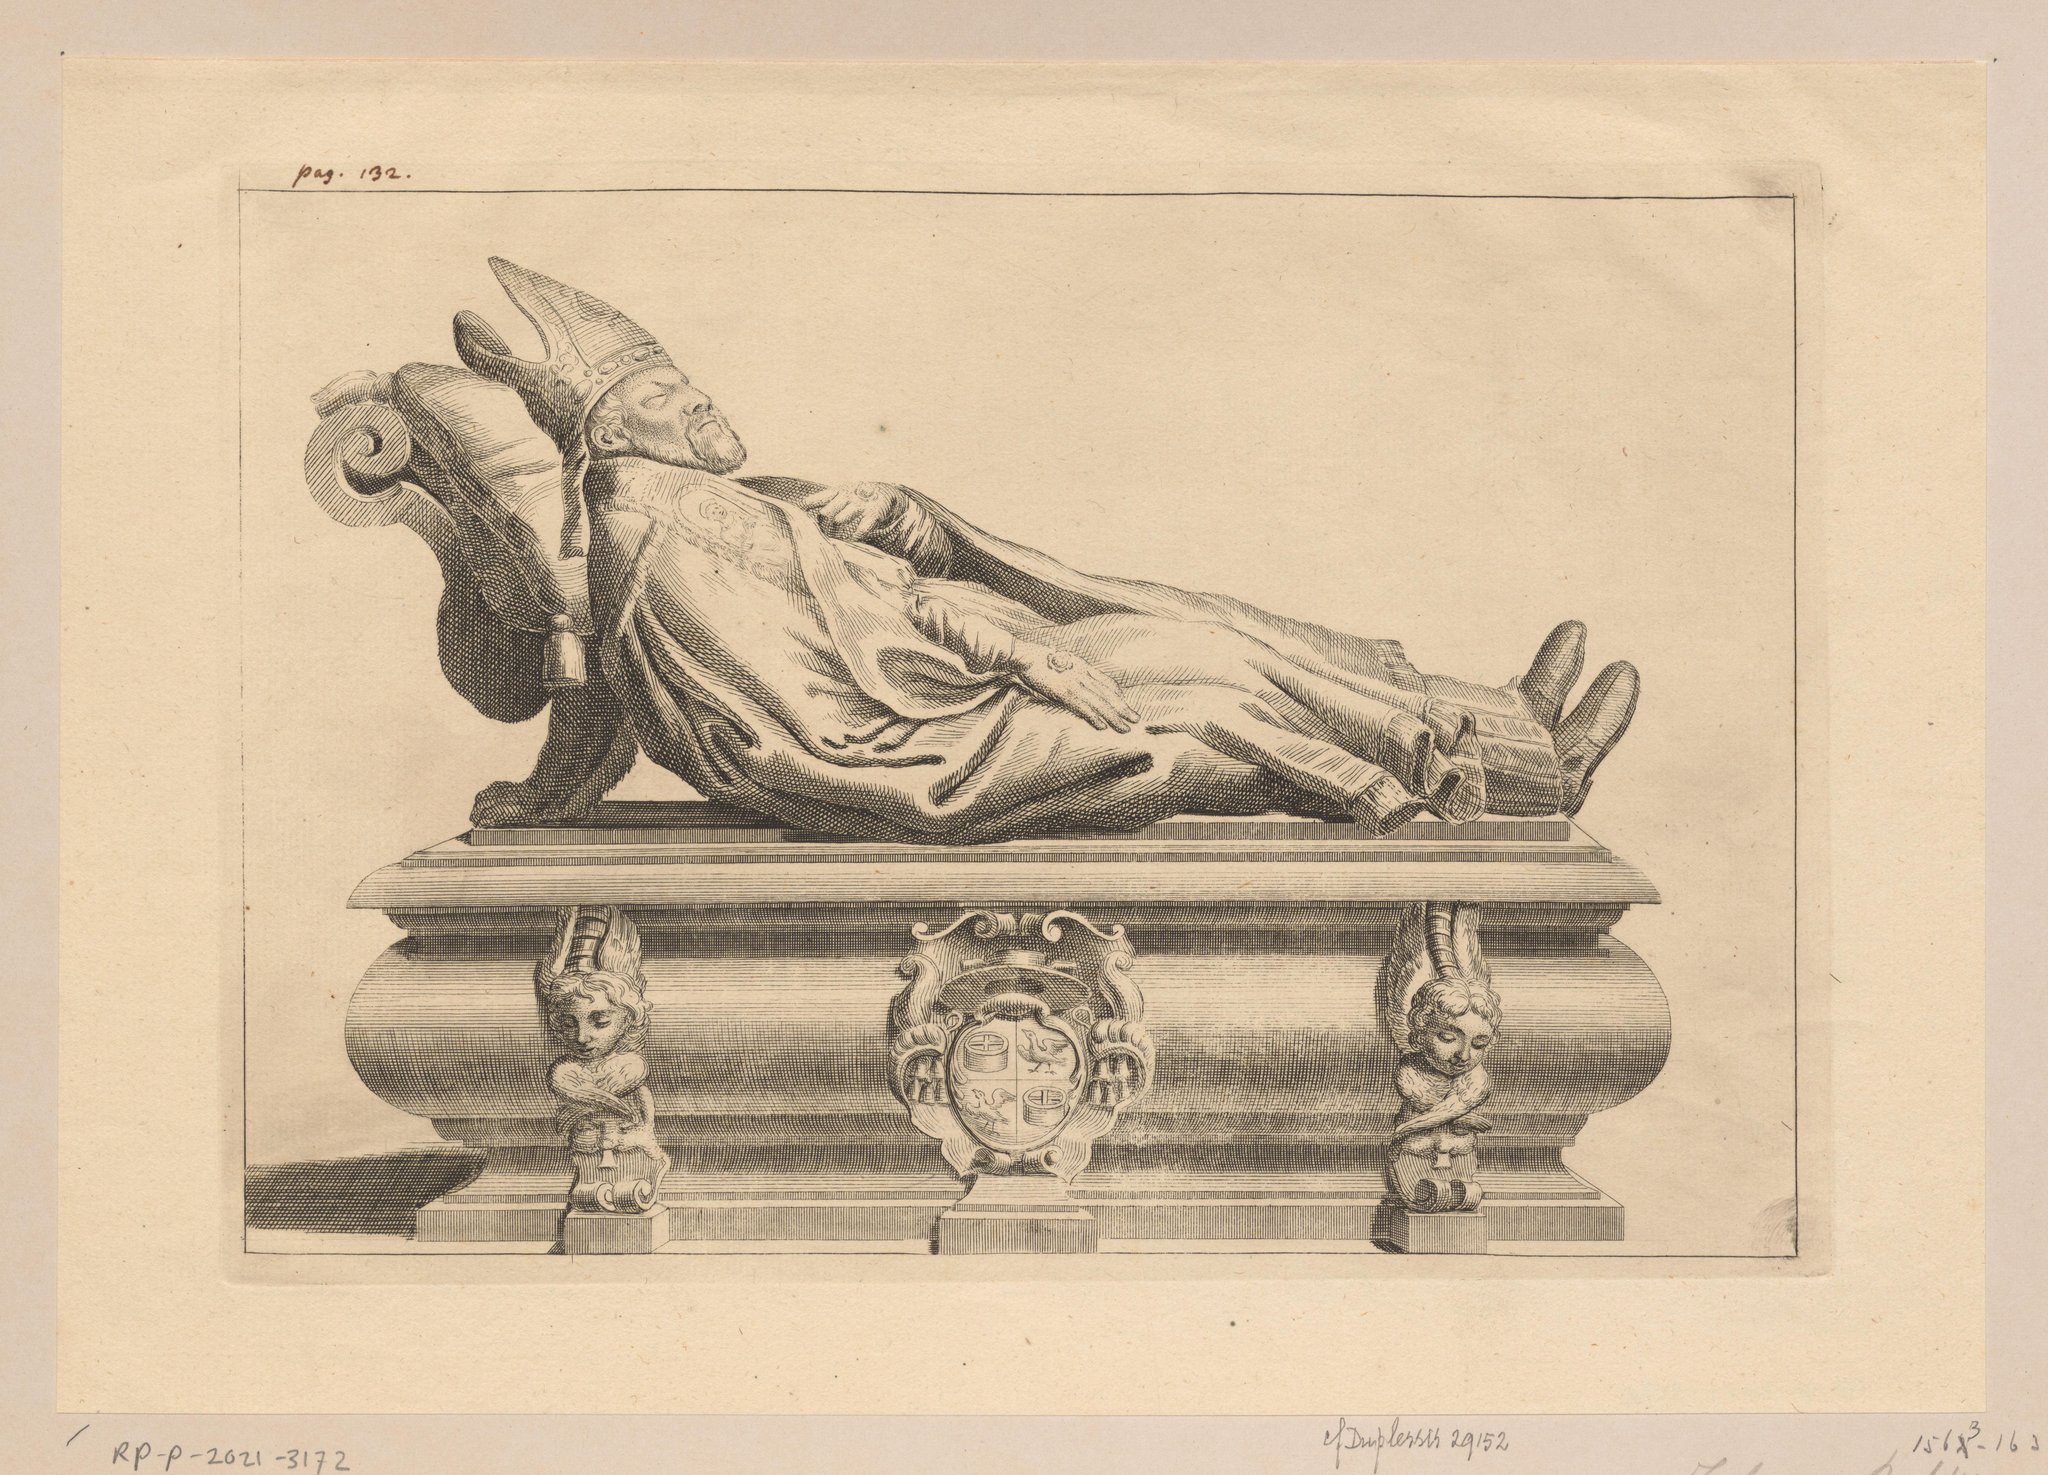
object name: print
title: Graf van Johannes Malderus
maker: Anonymous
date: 1700-1799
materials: paper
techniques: engraving, etching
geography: low countries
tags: johannes malderus, archbishop, bishop, etc. (roman catholic), historical persons, grave, tomb, armorial bearing, heraldry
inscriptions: inscription: ‘pag. 132’